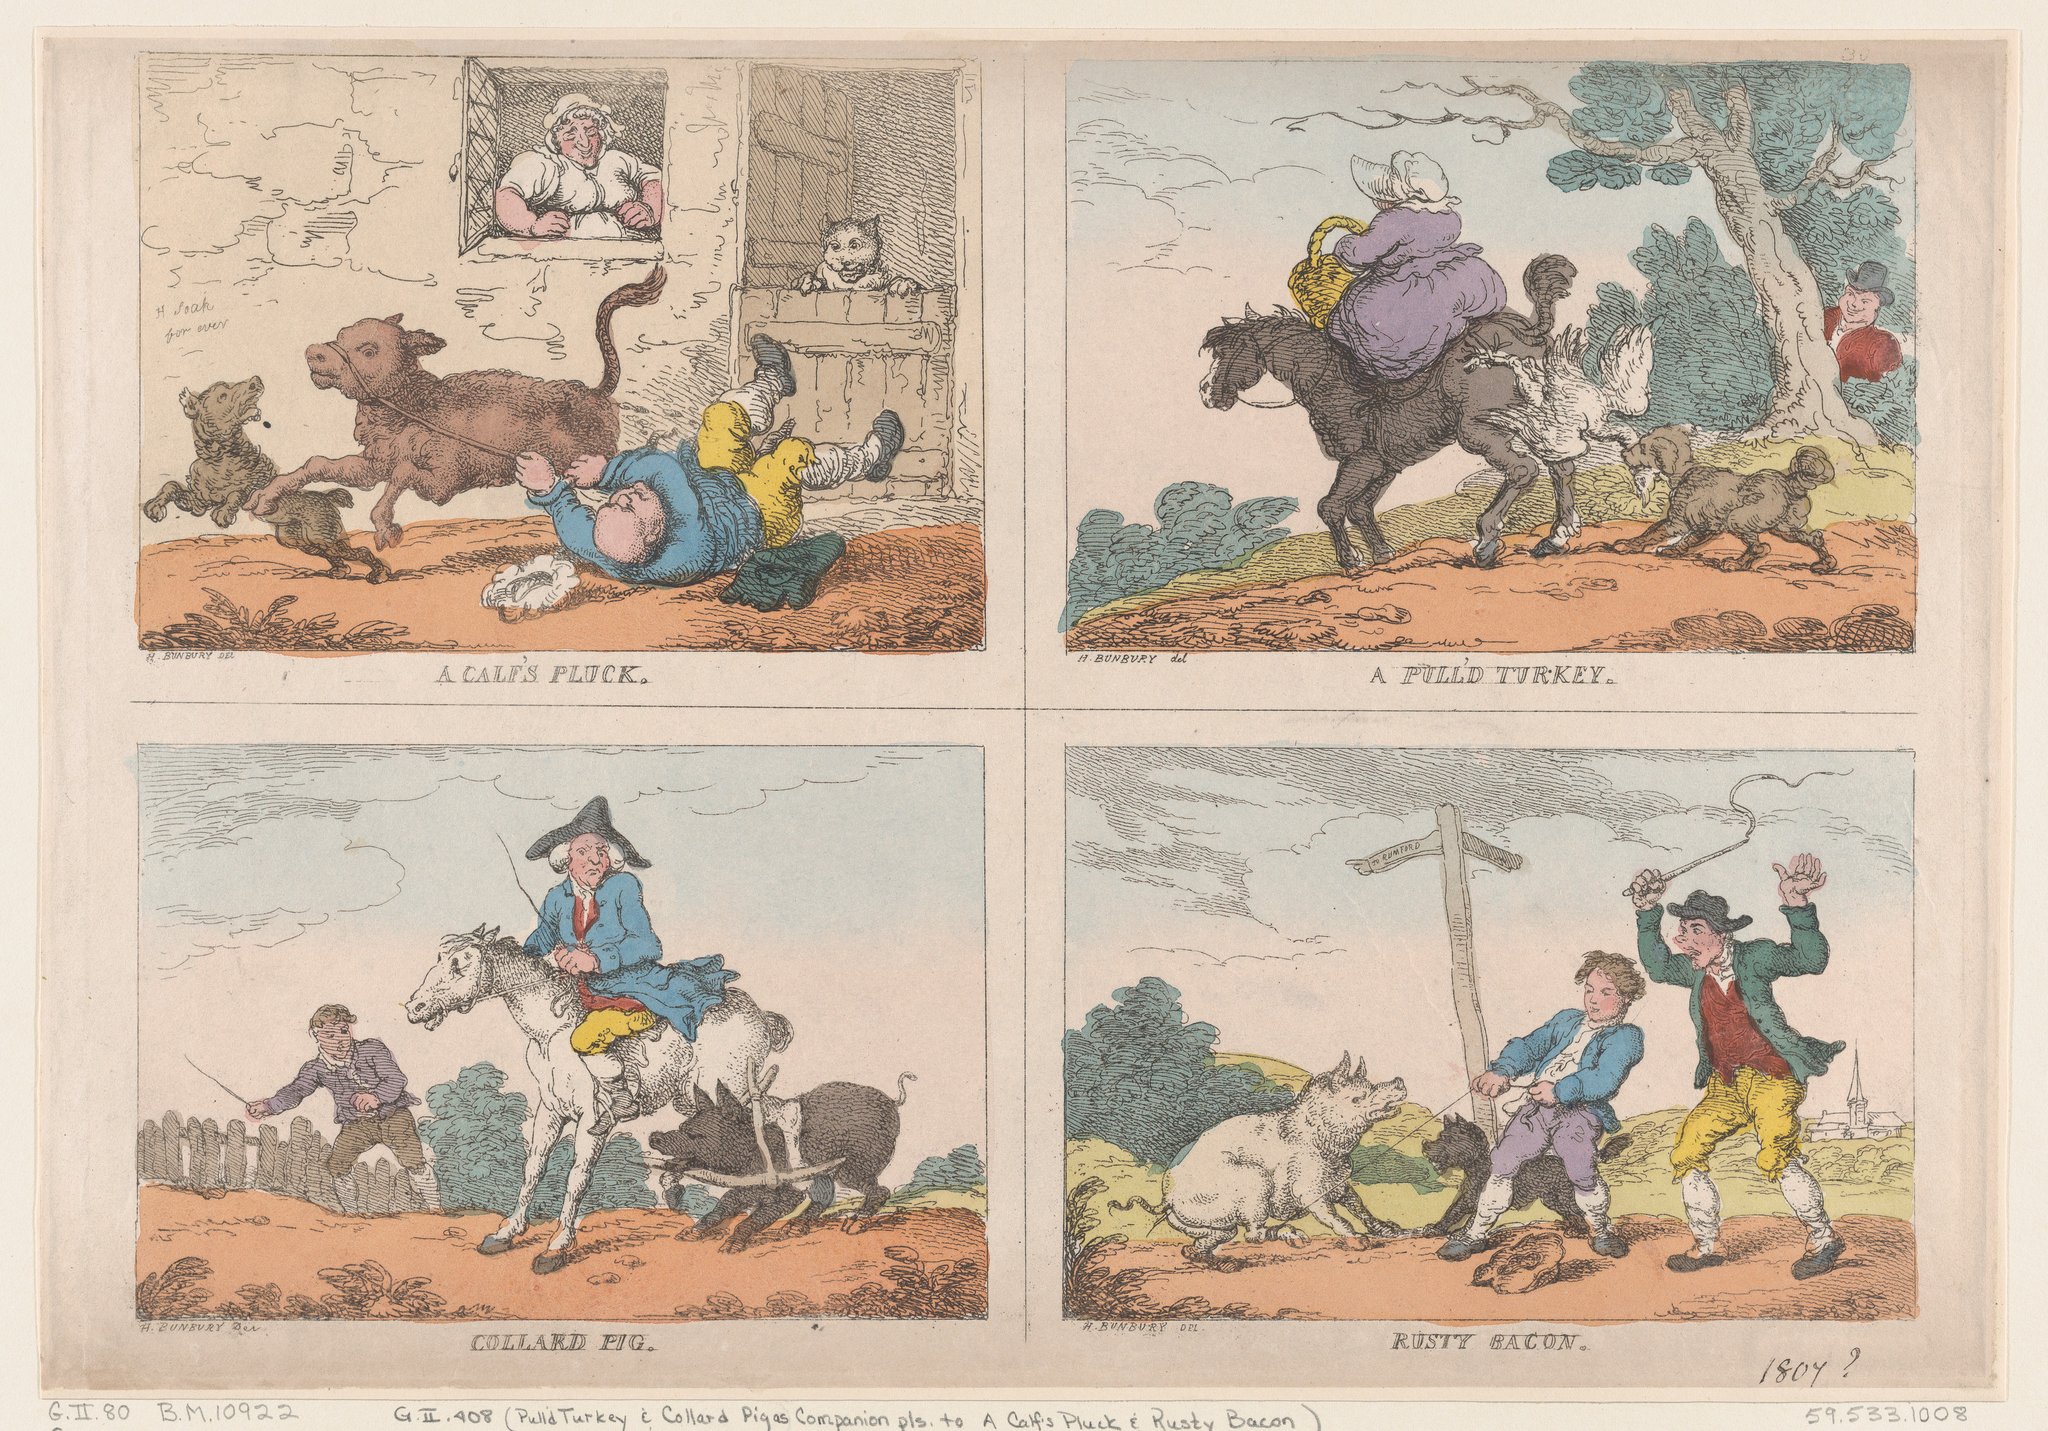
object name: print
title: Pull'd Turkey, Collard Pig, A Calf's Pluck and Rusty Bacon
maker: thomas rowlandson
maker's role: artist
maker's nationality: british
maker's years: 1757-1827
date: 1807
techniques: etching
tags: animals,men,women,horses